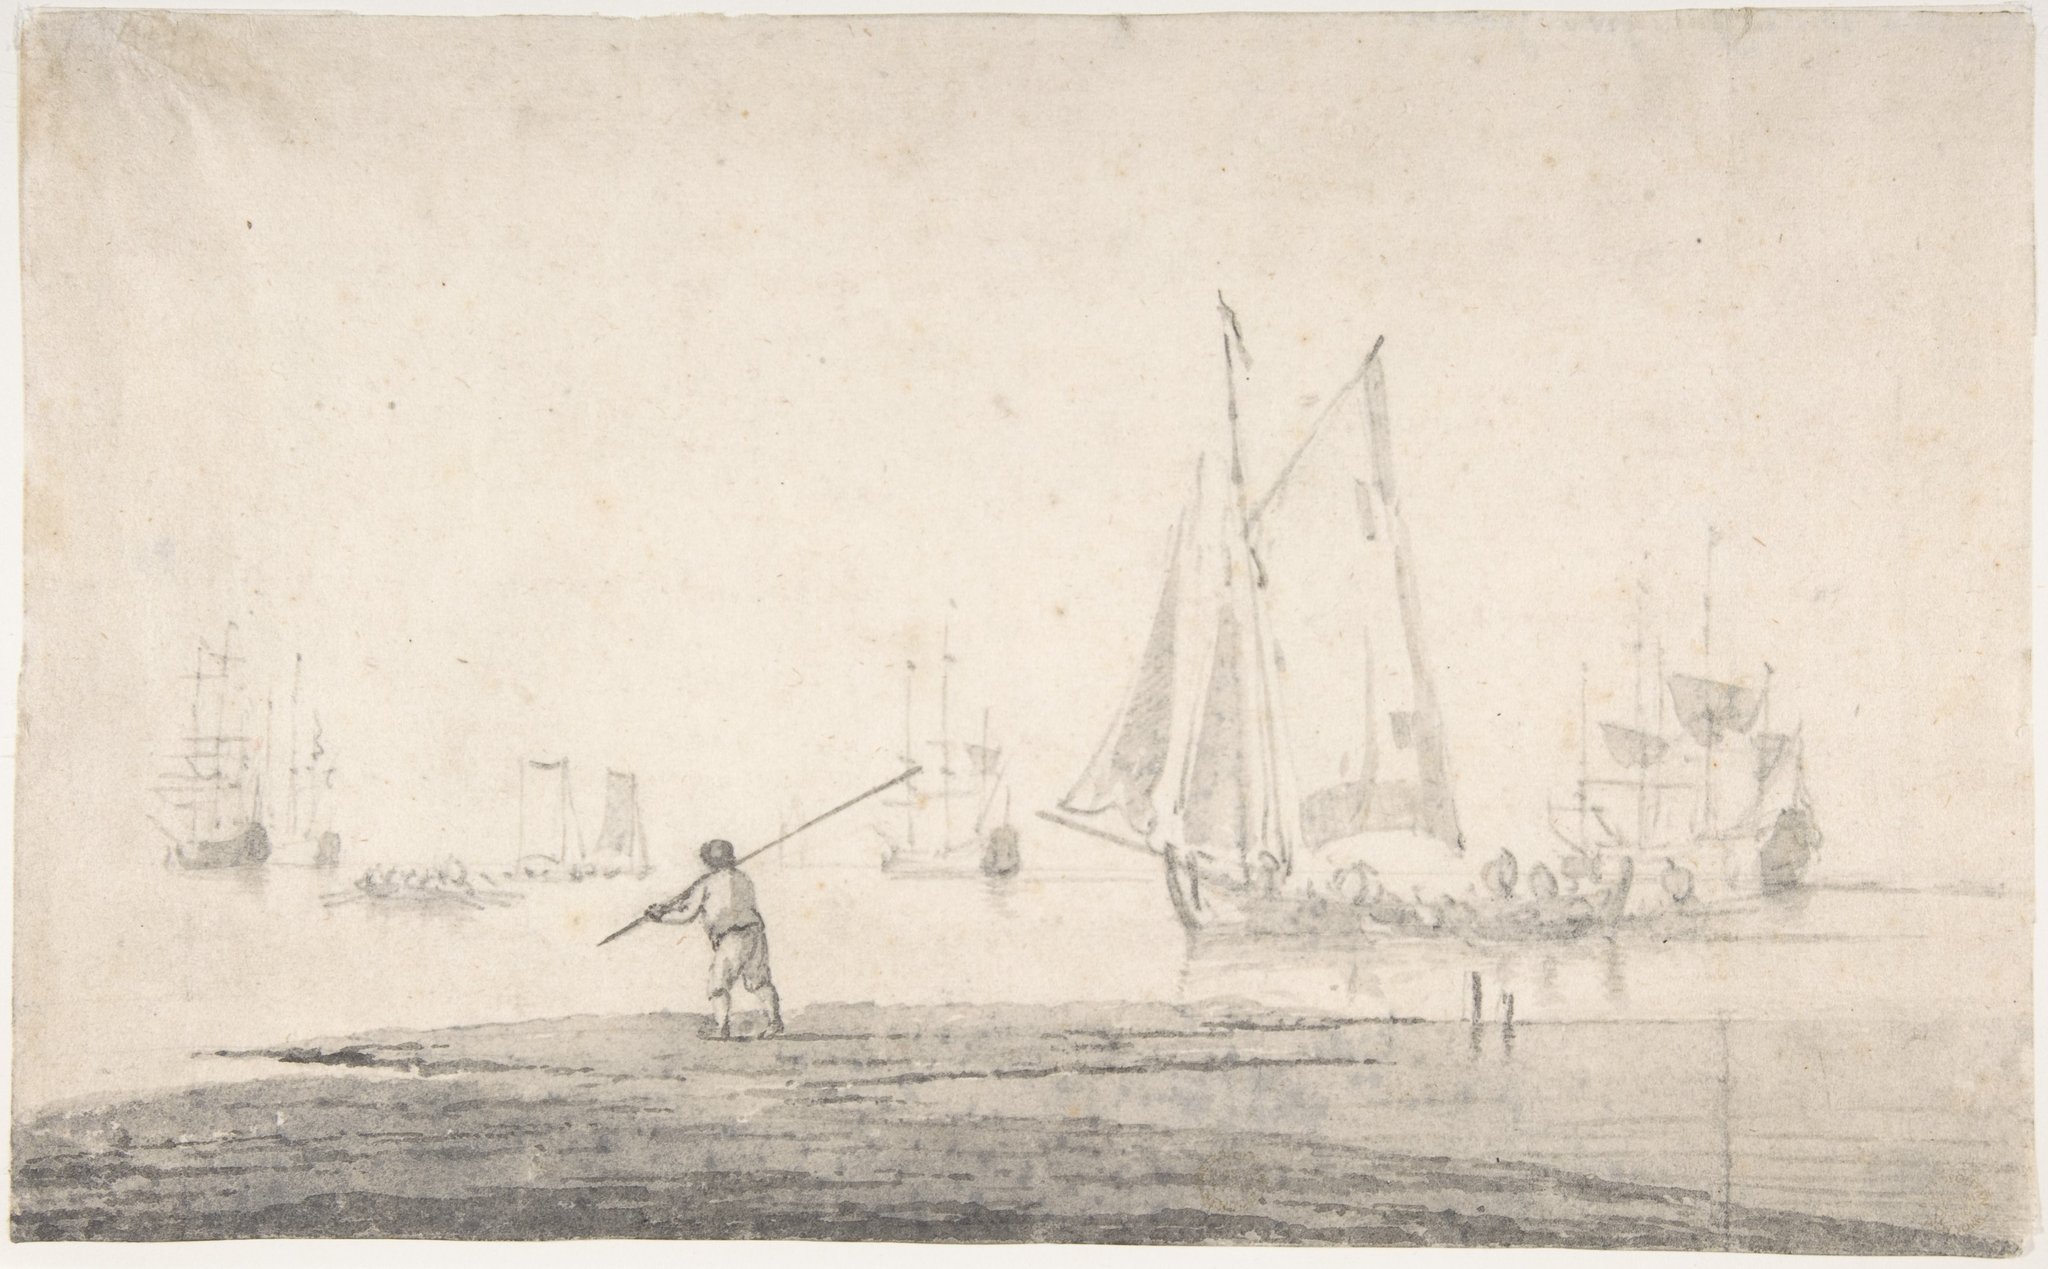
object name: drawing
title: Boats Becalmed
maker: willem van de velde (ii)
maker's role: artist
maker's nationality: dutch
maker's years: 1633-1707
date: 1634-1733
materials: graphite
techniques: brush, wash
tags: men,boats